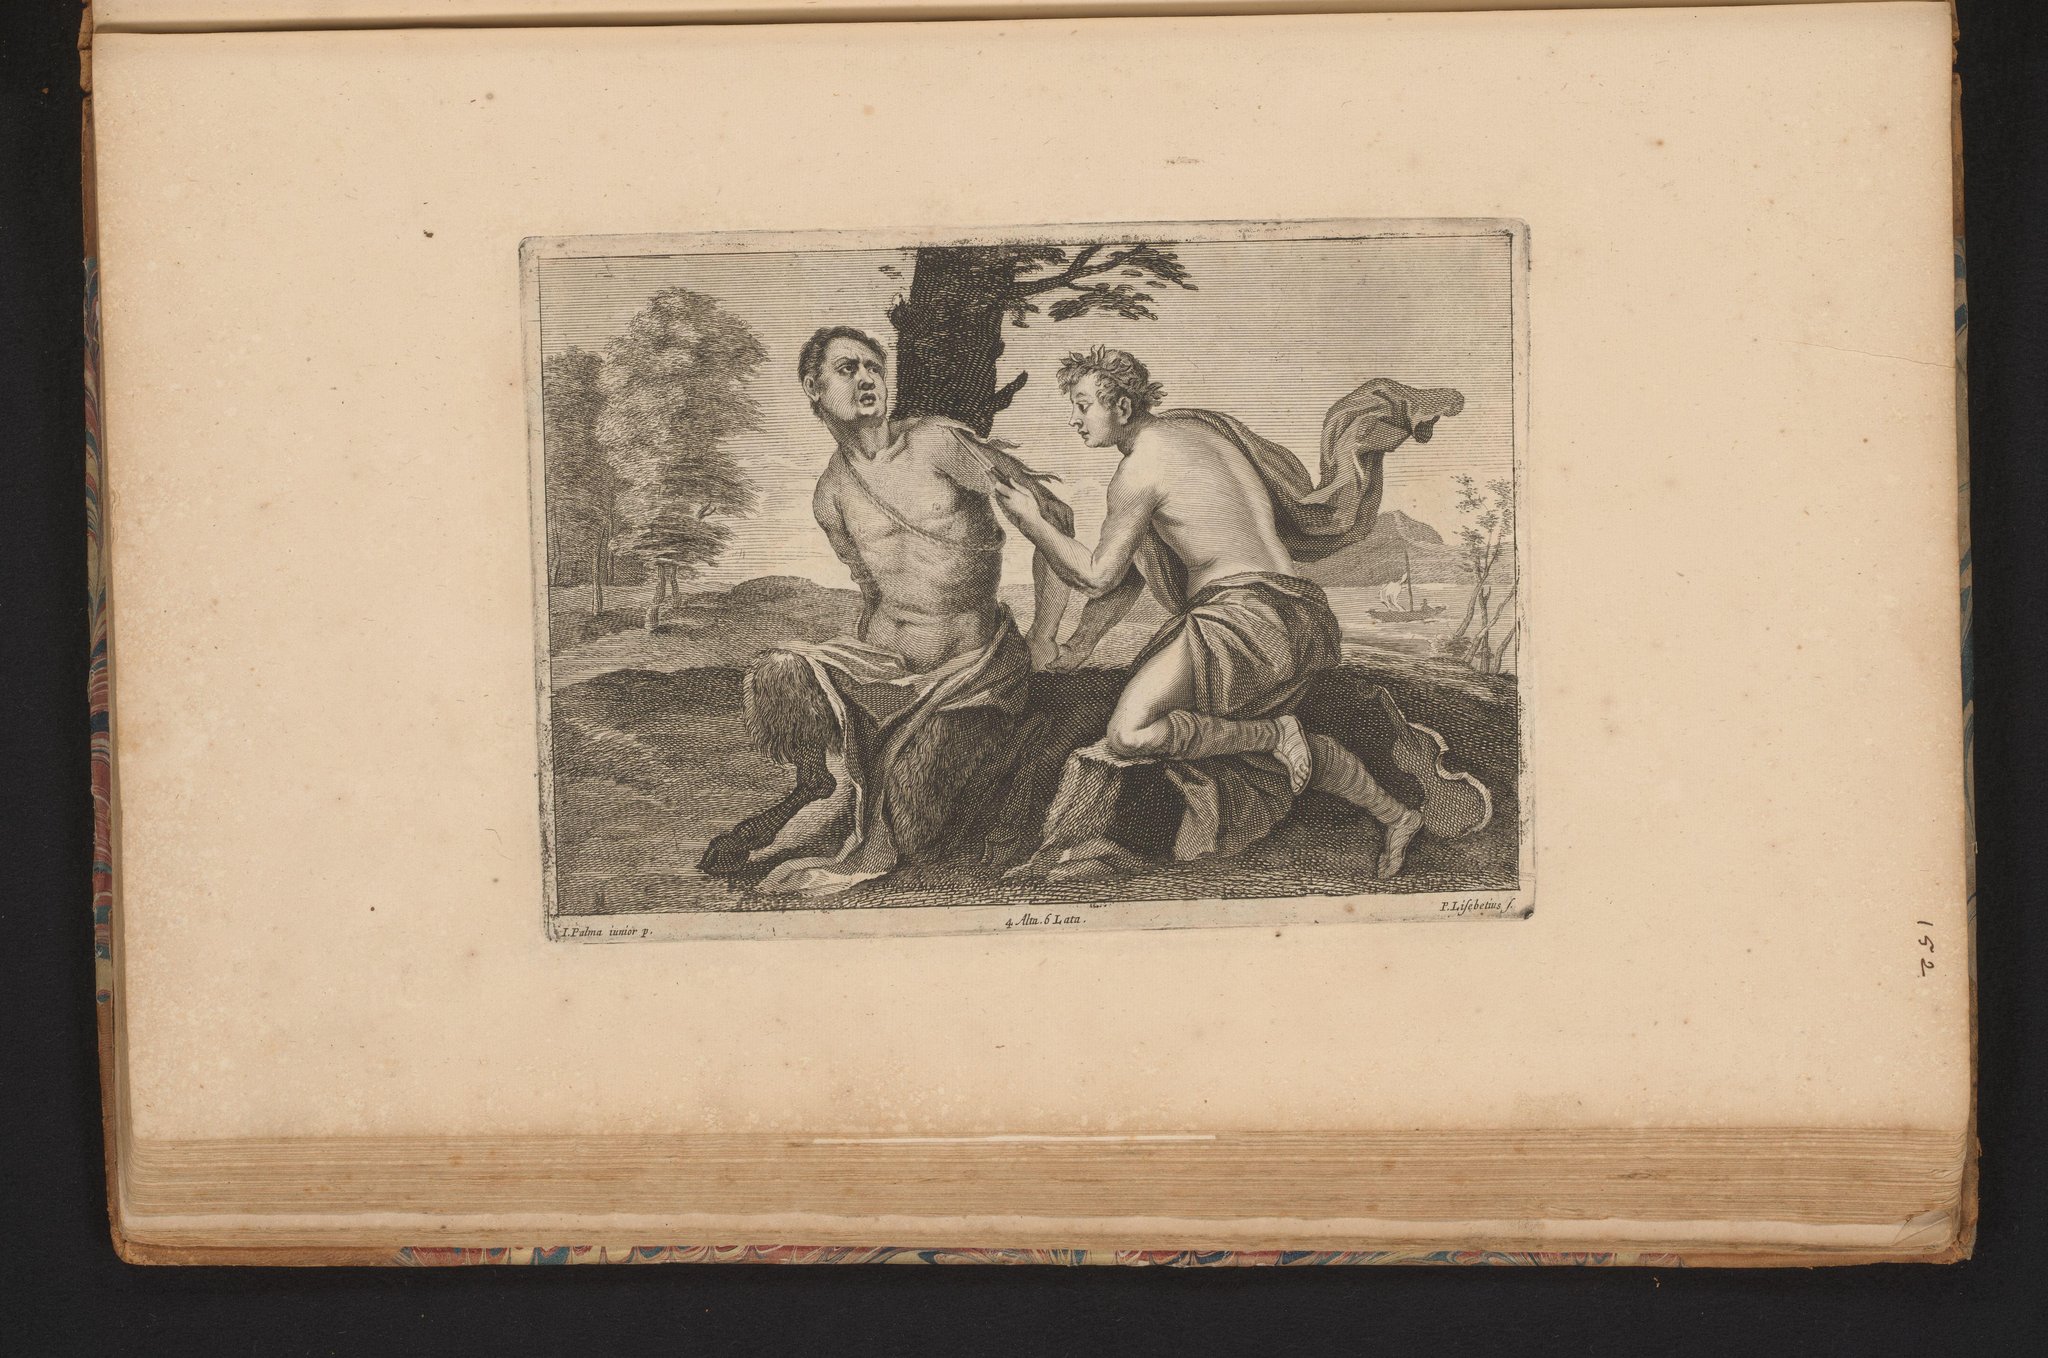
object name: print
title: Apollo vilt Marsyas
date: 1660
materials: paper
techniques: engraving, etching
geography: brussels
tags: punishment of marsyas: he is flayed by apollo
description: David Teniers heeft waarschijnlijk van alle schilderijen uit de collectie van Leopold Willem van Oostenrijk een olieverfstudie op doek of paneel vervaardigd (zgn. pasticcio), die als voorbeeld voor de prentmakers diende. Het is niet altijd duidelijk of de pasticci door hem zijn gemaakt of door zijn atelier. Niet alle pasticci zijn overgeleverd.